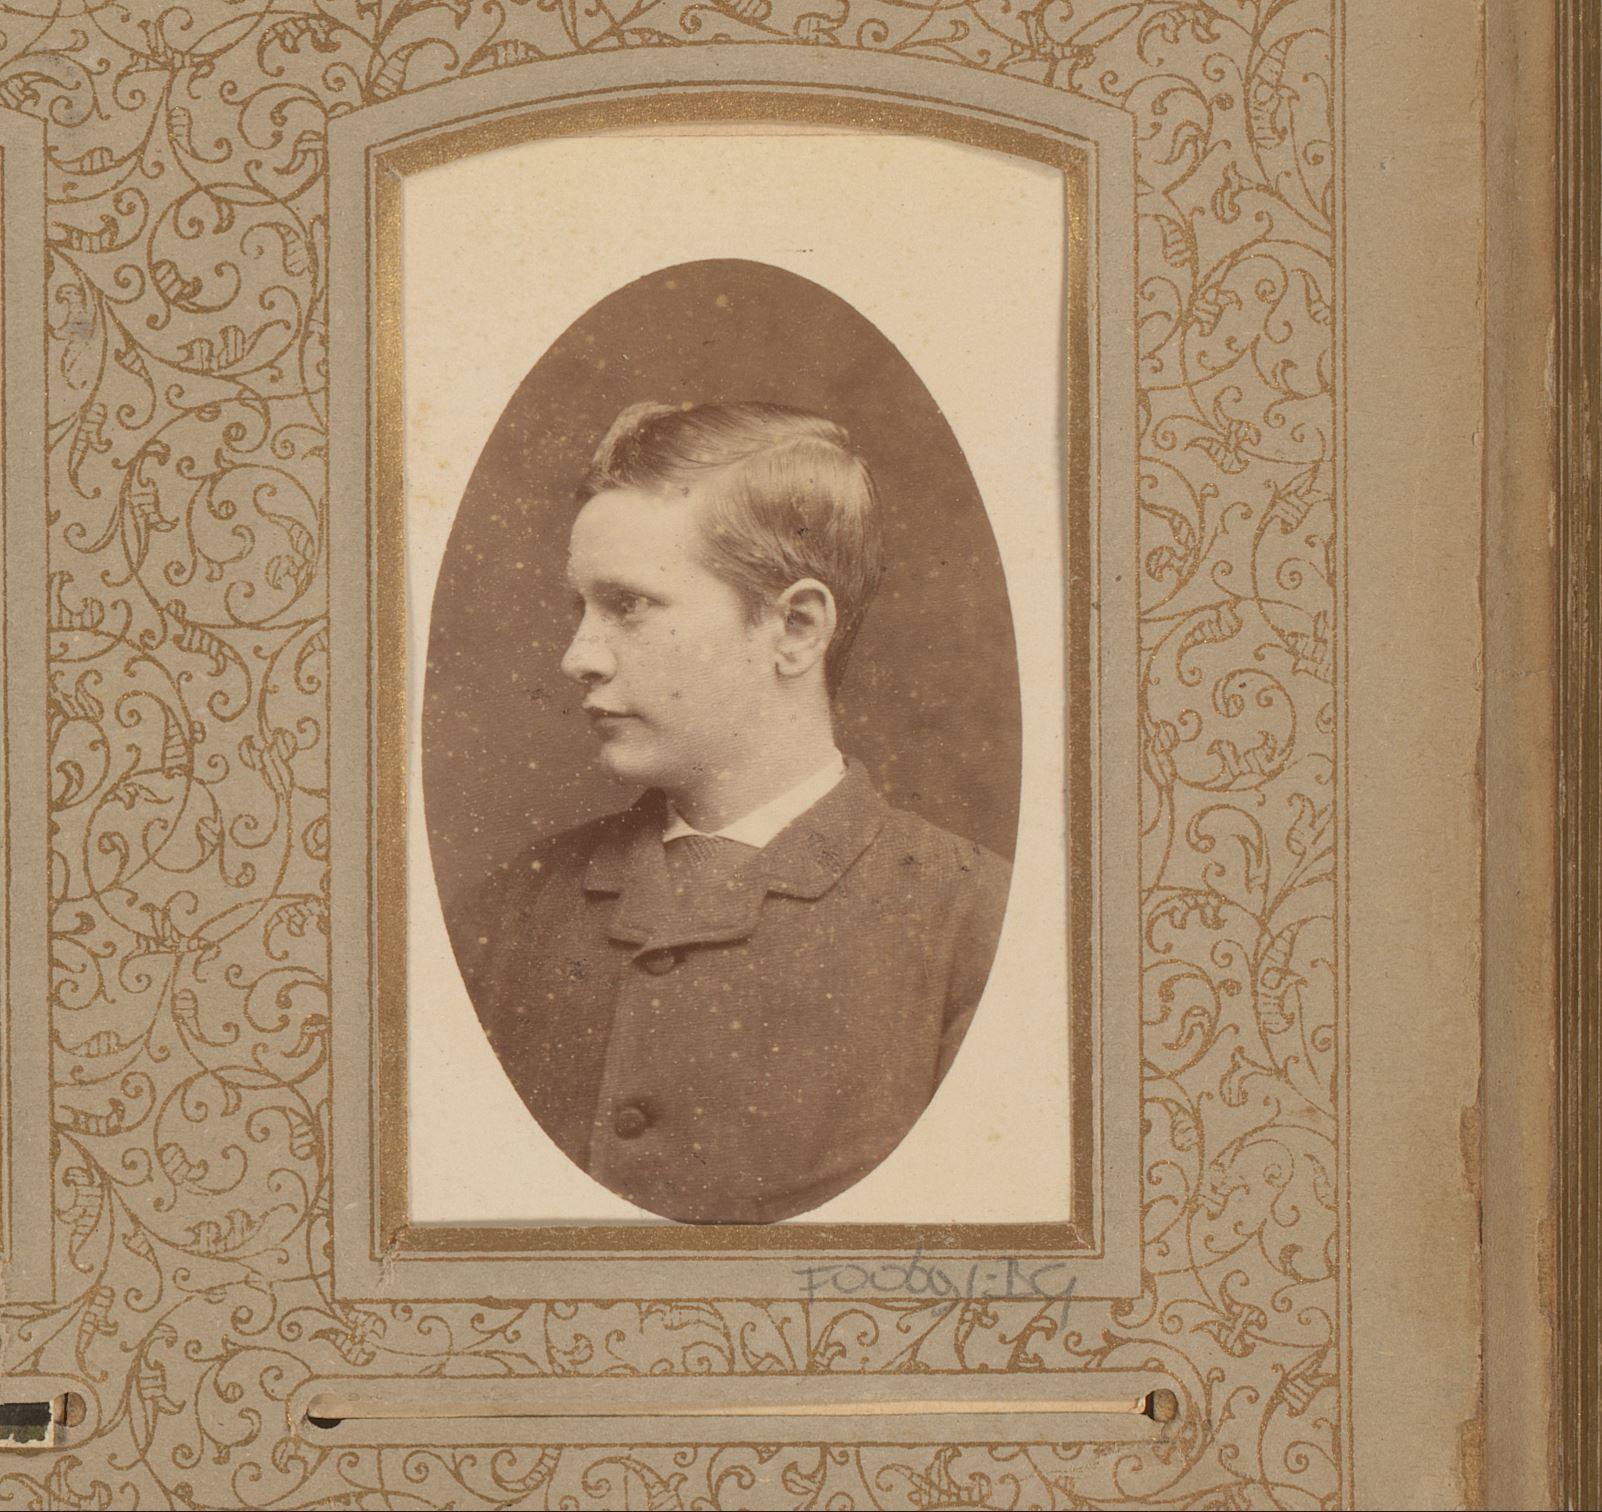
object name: photograph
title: Portret van een jongen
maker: b.j. pottjewijd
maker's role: fotograaf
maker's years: 1859-1941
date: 1880-1900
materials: cardboard, photographic support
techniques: albumen print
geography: winschoten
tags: adolescent, young woman, maiden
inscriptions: inscription: ‘B.J. Pottjewijd/ Winschoten’